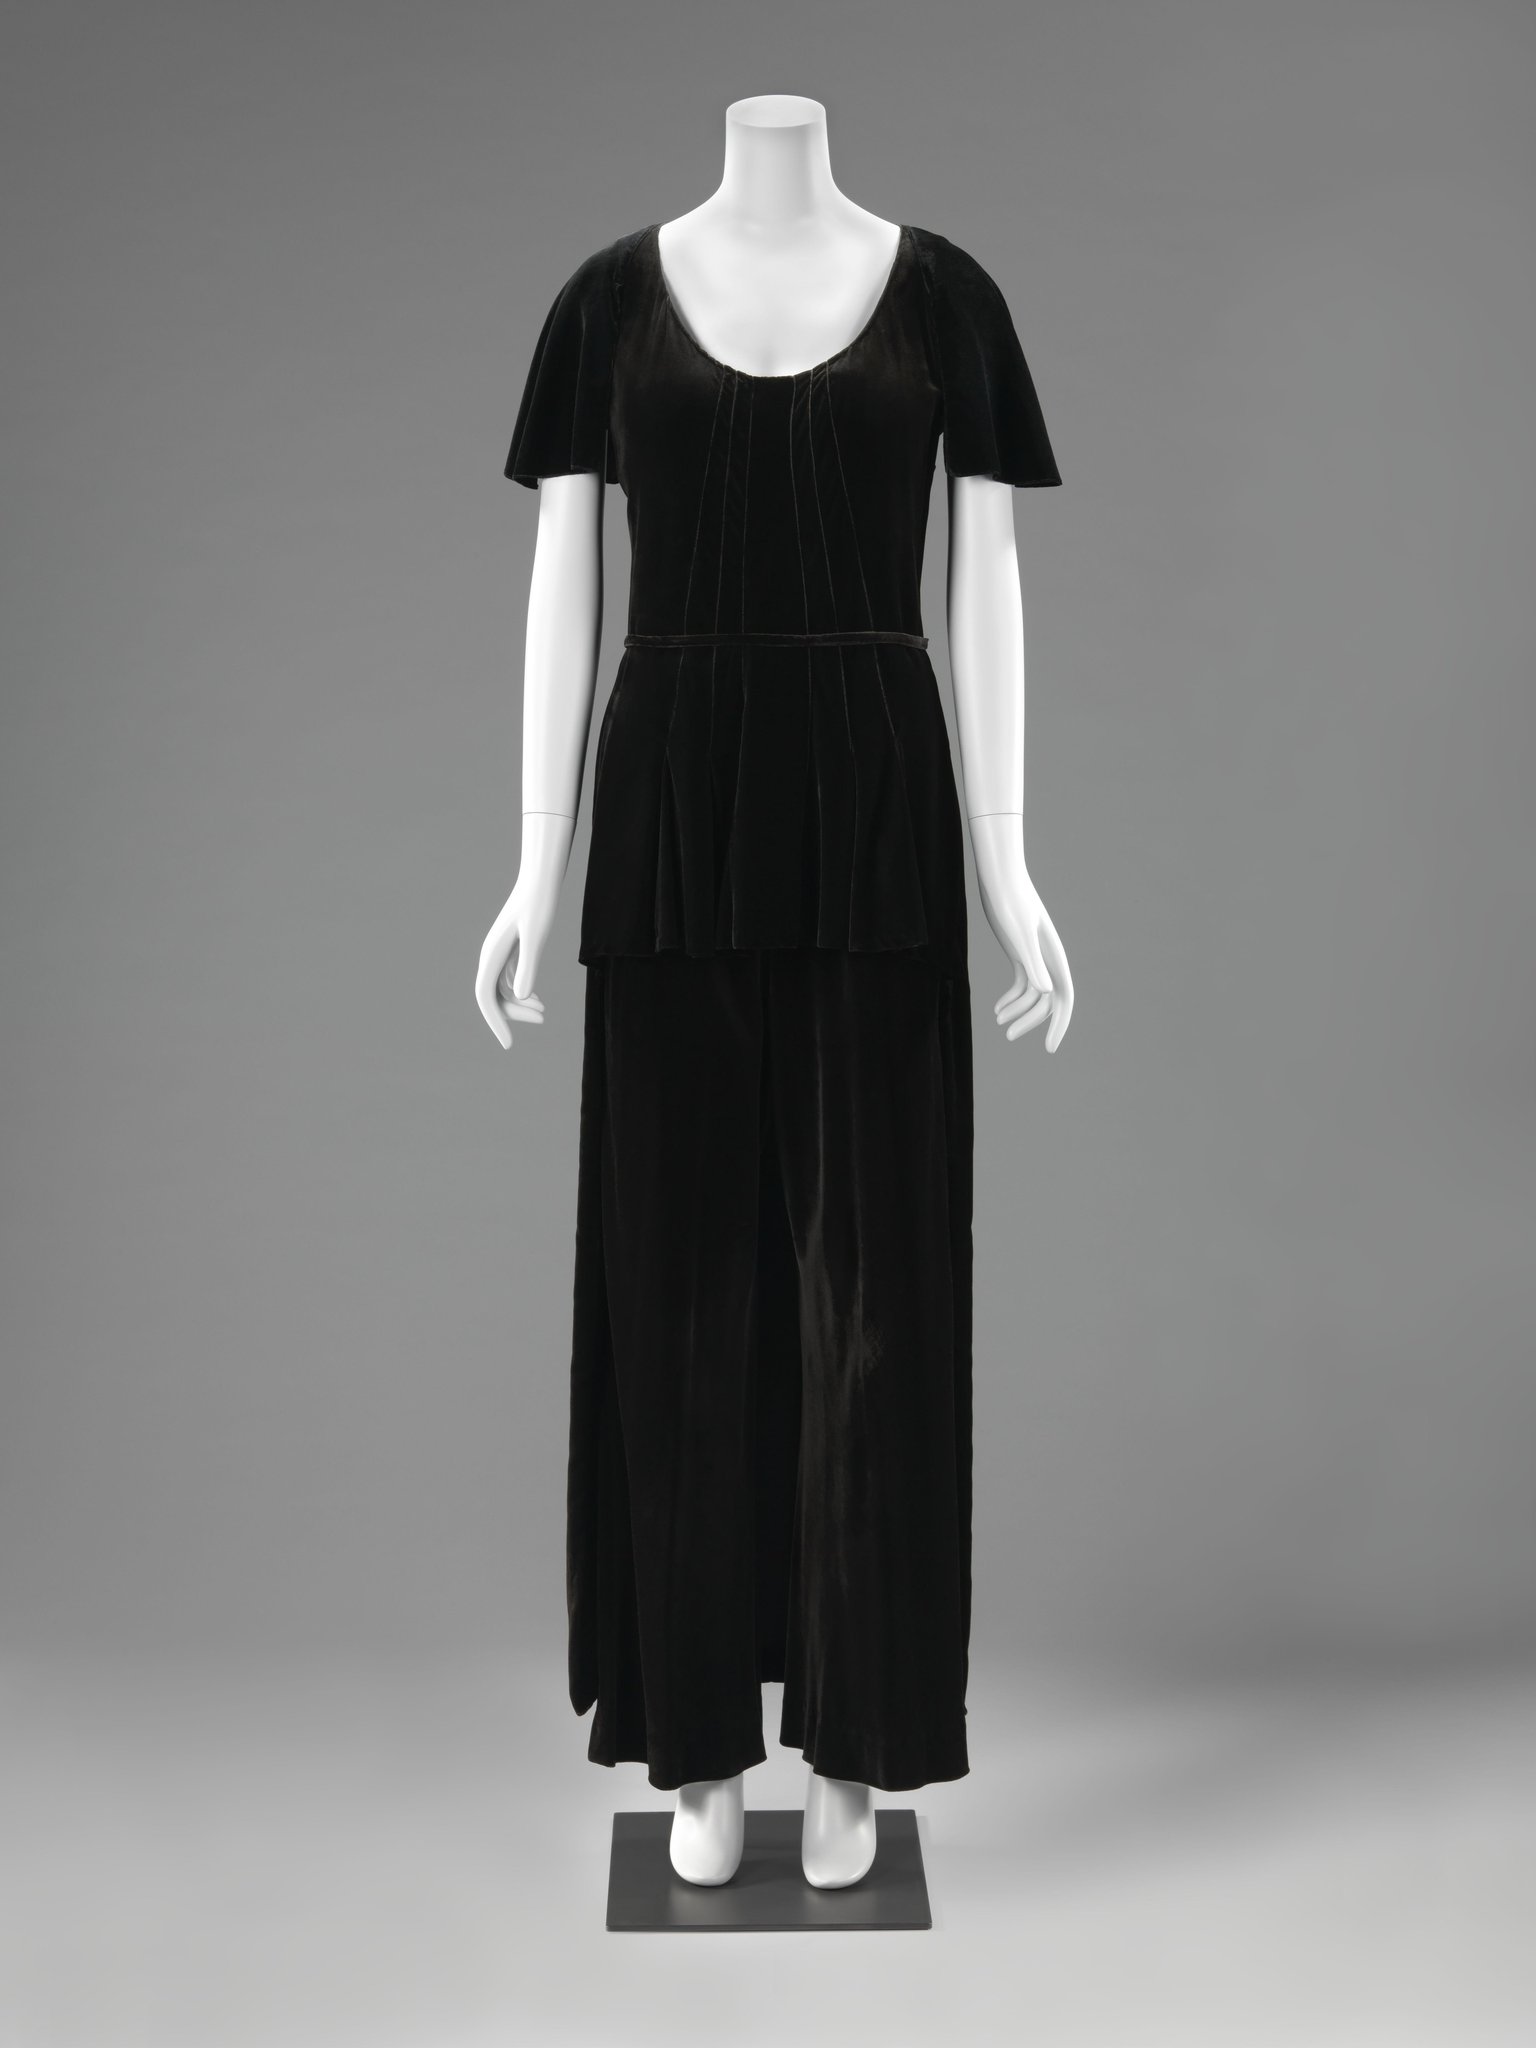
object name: main garment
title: Lounging Pyjamas with Train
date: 1925-1930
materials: chine, silk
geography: brussels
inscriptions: name: ‘Pyjama Abdulah/ Chanel’, number: ‘0848’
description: In the 1920s fashionable young women wore pyjamas as loungewear. Around 1930 they also began to wear them when they went out to dine with friends. These pyjamas may have been the creation of the famous French fashion designer Gabriëlle Chanel. A label is sewn into the left trouser leg on which is written: ‘Pyjama Abdulah, Chanel.’